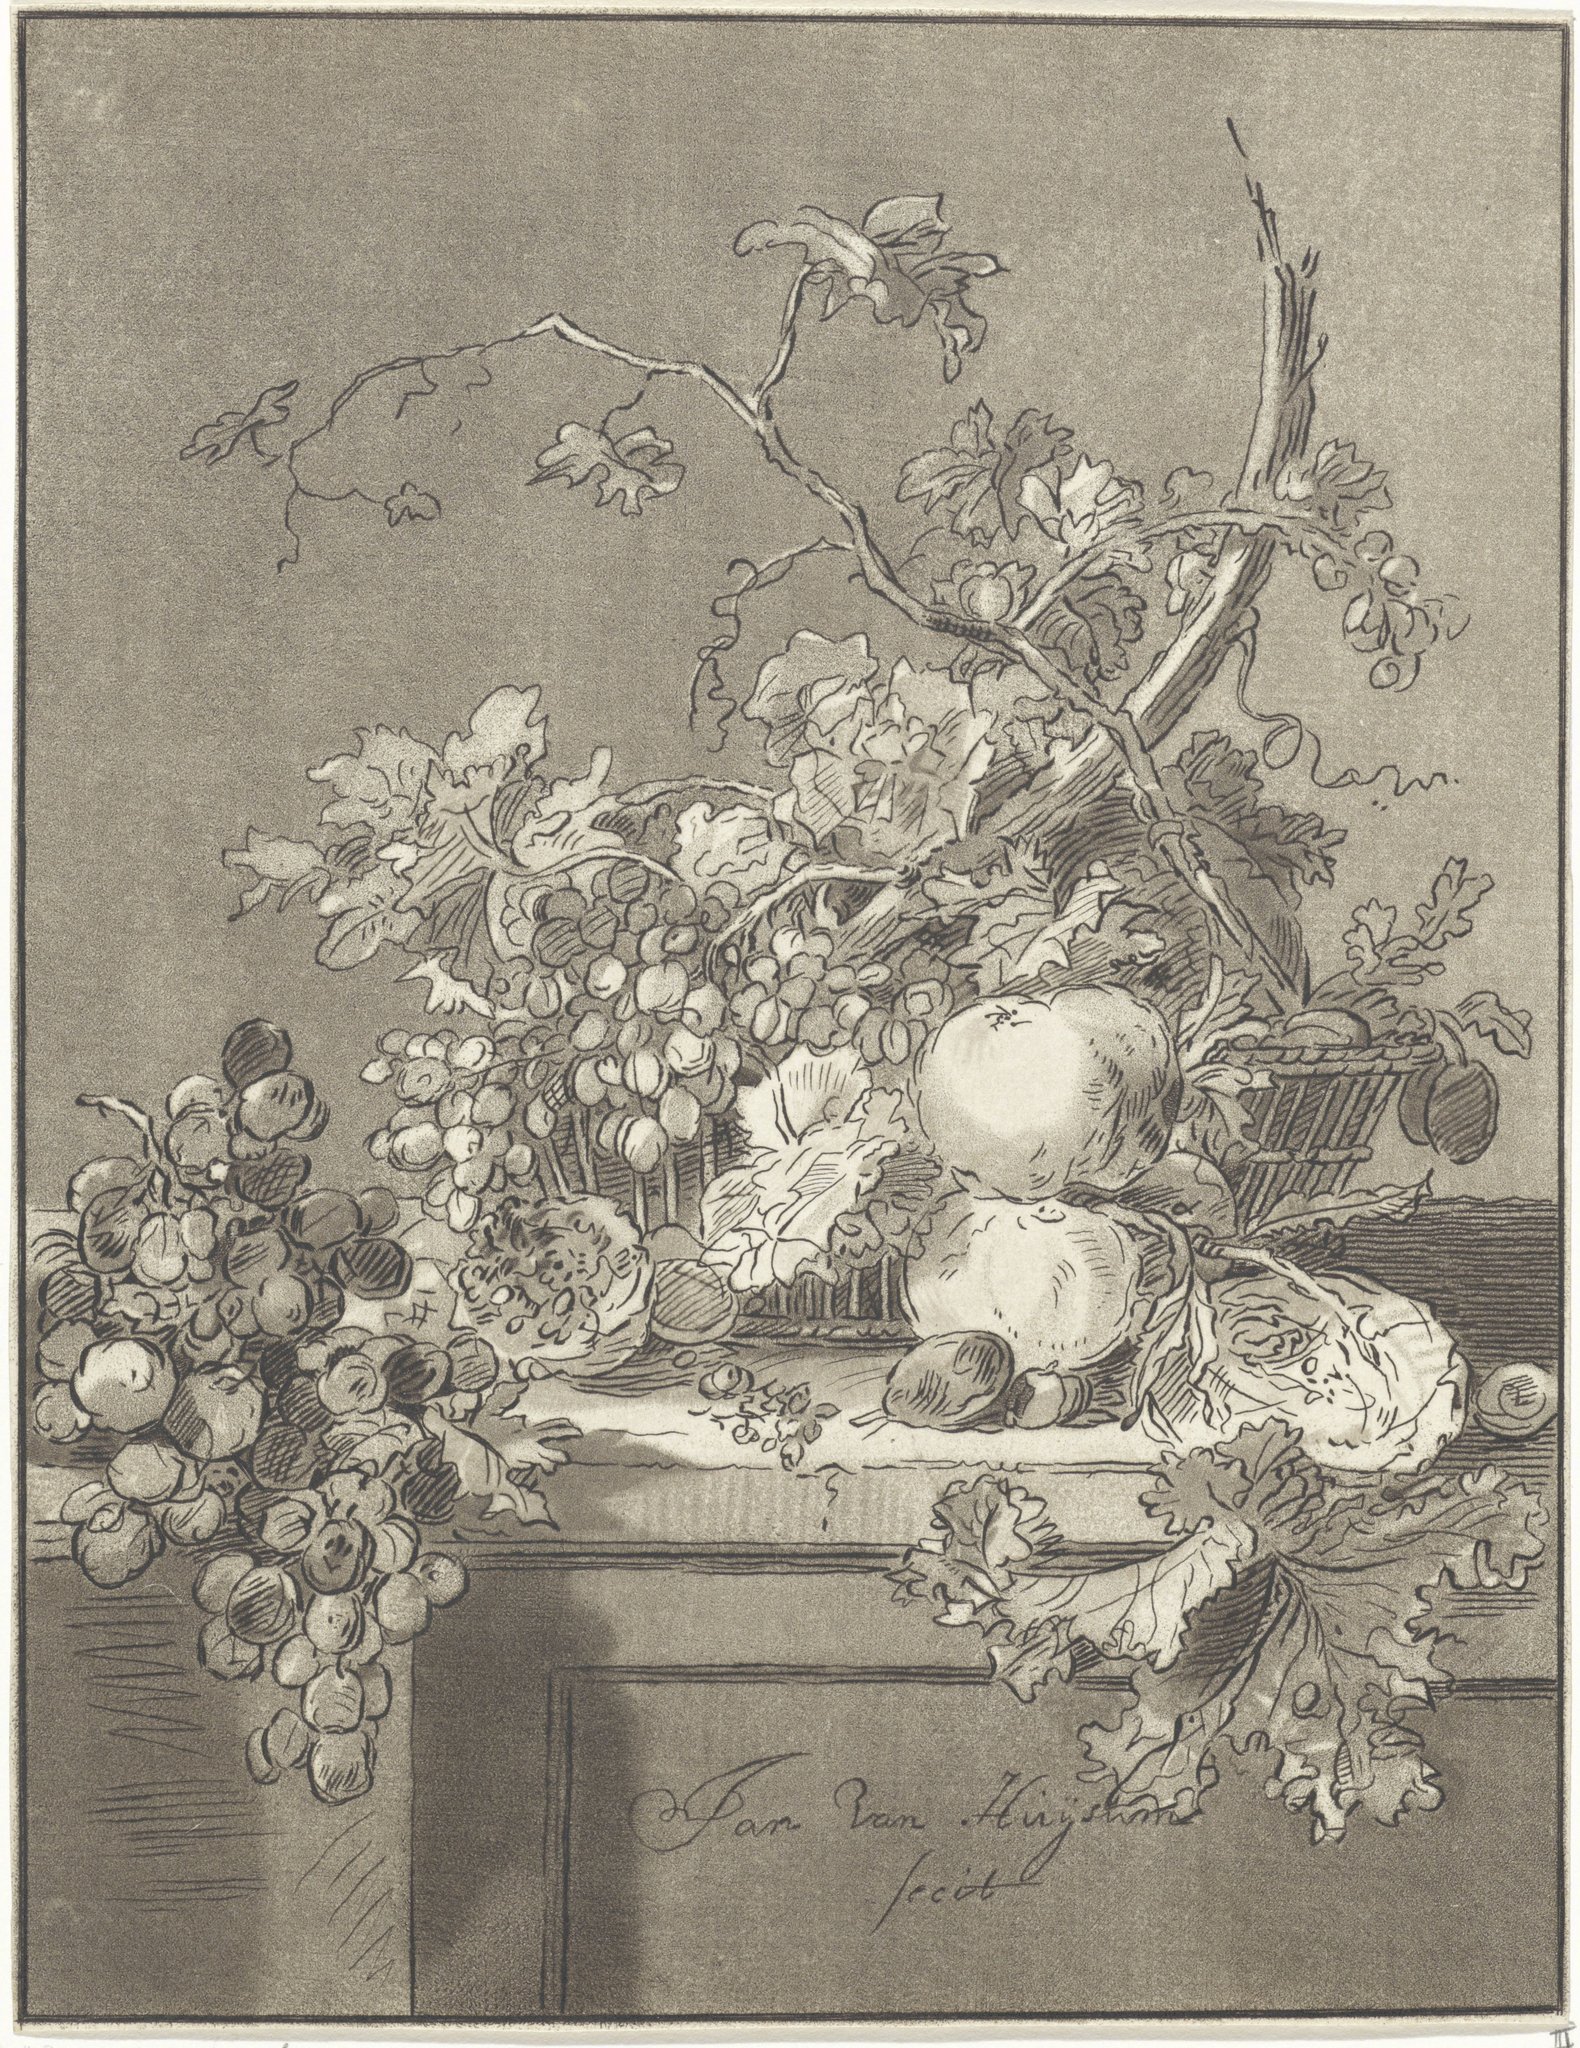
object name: print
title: Mand met vruchten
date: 1767-1780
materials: paper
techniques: etching, rocker stamped, roulette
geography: netherlands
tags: fruit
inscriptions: collector's mark: Lugt 240